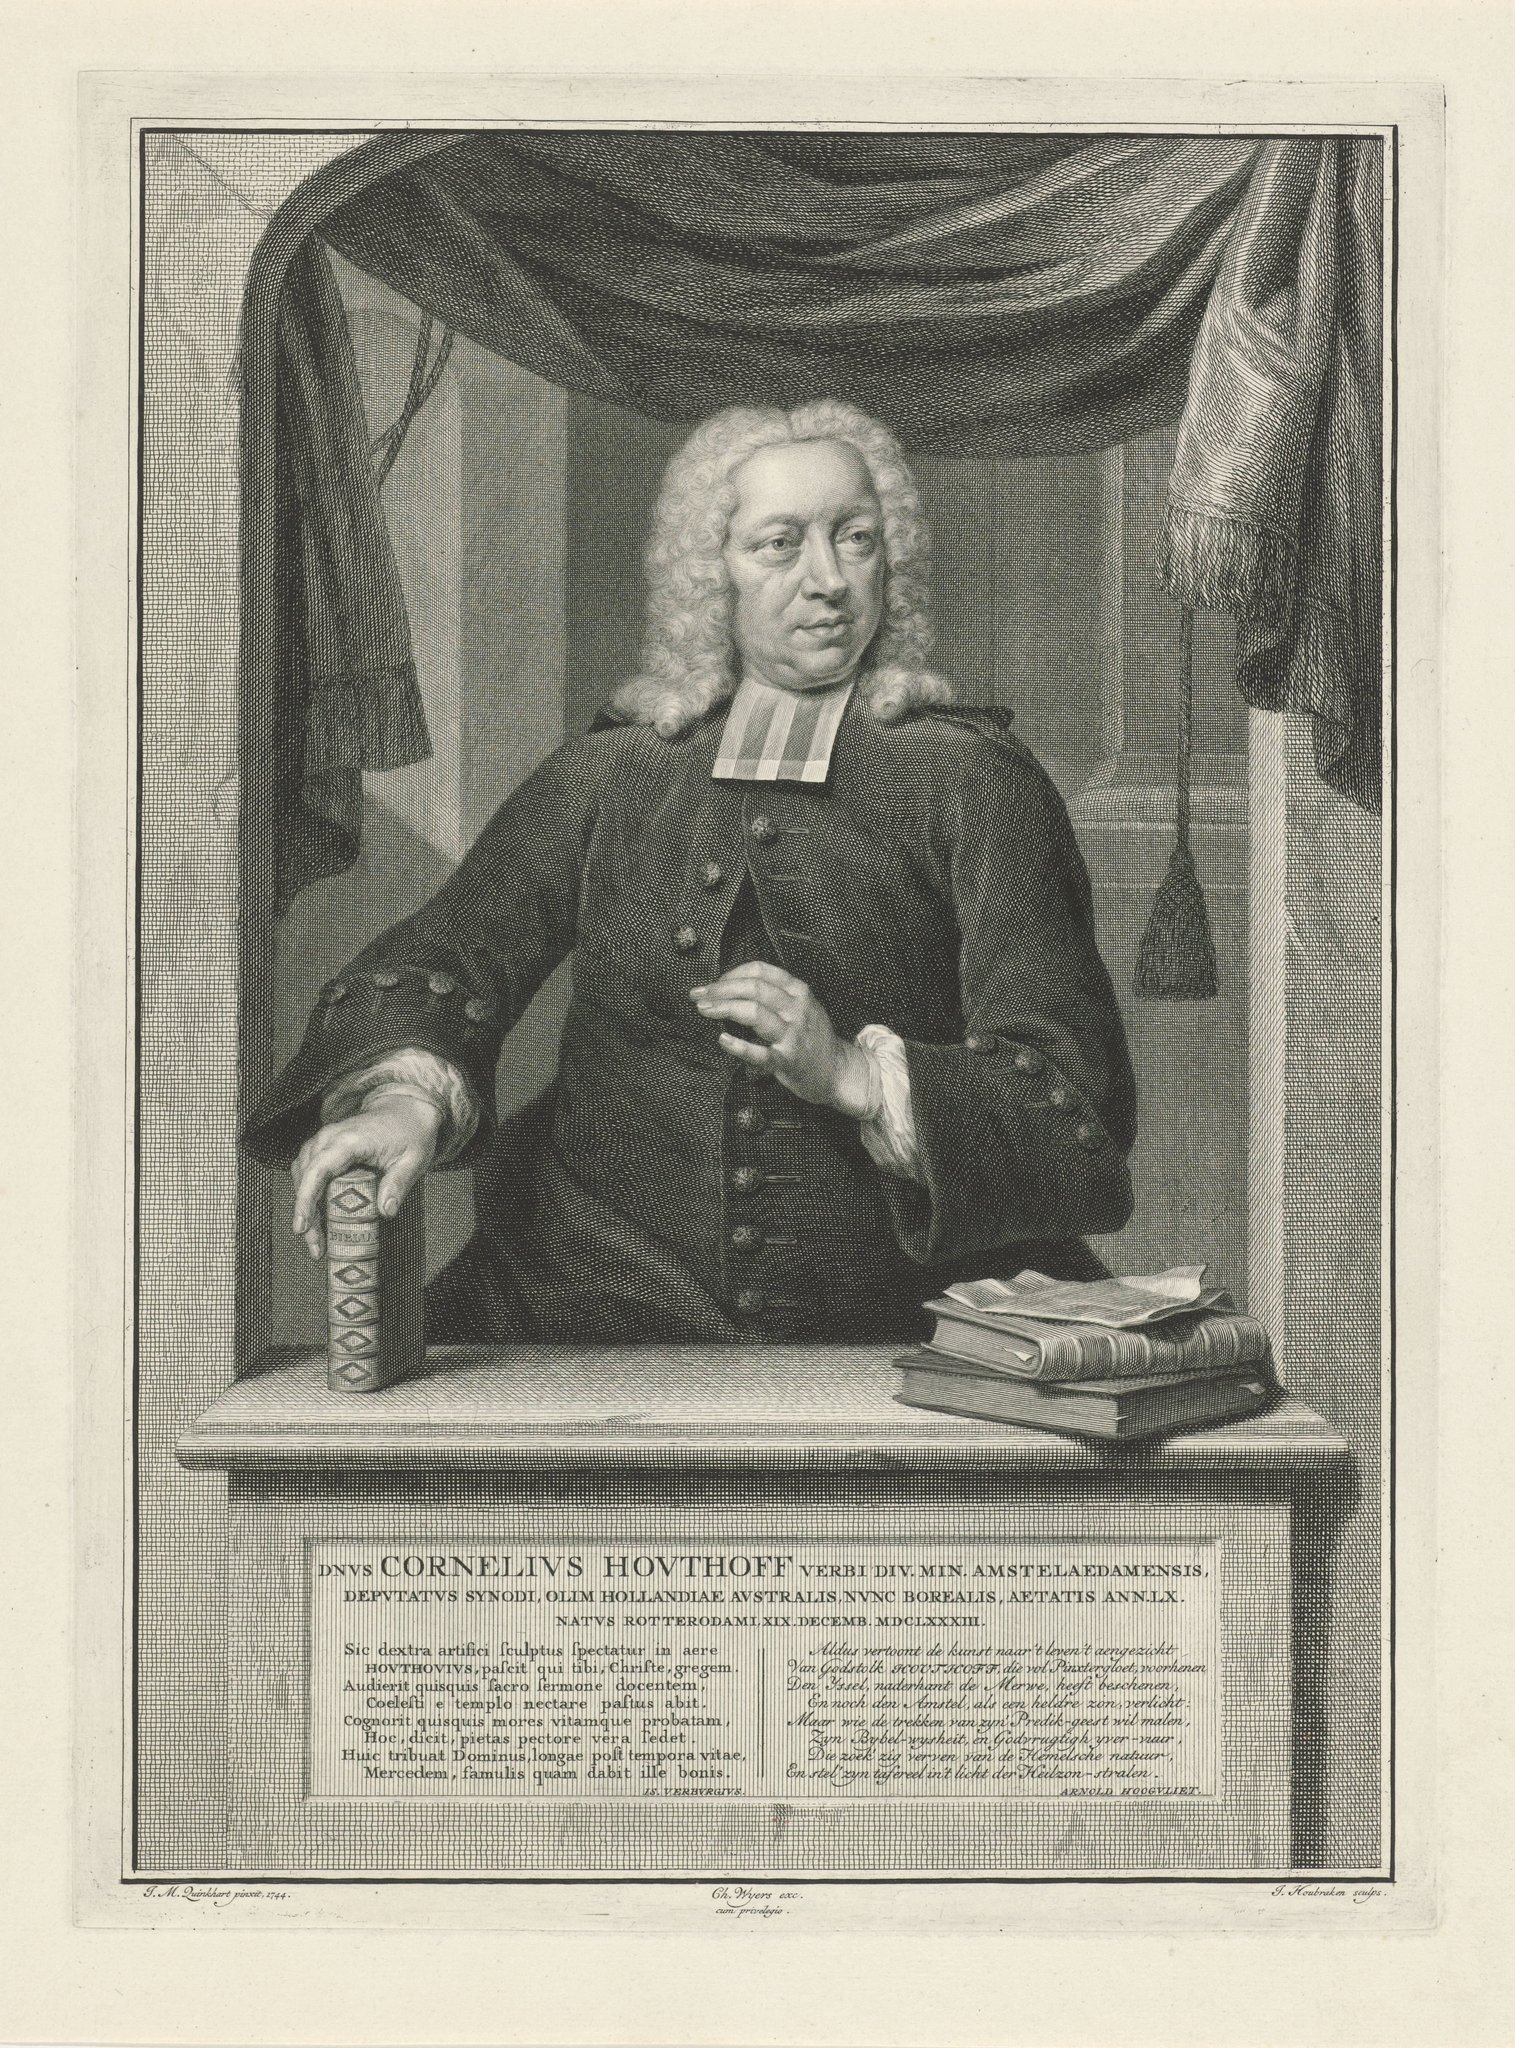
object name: print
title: Cornelivs Hovthoff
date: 1744-1745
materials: paper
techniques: engraving, etching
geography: amsterdam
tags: rotterdam, the bible as a book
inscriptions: collector's mark: Lugt 240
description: Cornelis Houthoff, ten halven lijve in een venster, bijbel in de rechterhand. Boven hem een gordijn en voor hem enkele boeken en een vel papier. Onder het portret zijn naam en gegevens in drie regels in het Latijn en daaronder twee kolommen met elk een achtregelig vers; links in het Latijn en rechts in het Nederlands